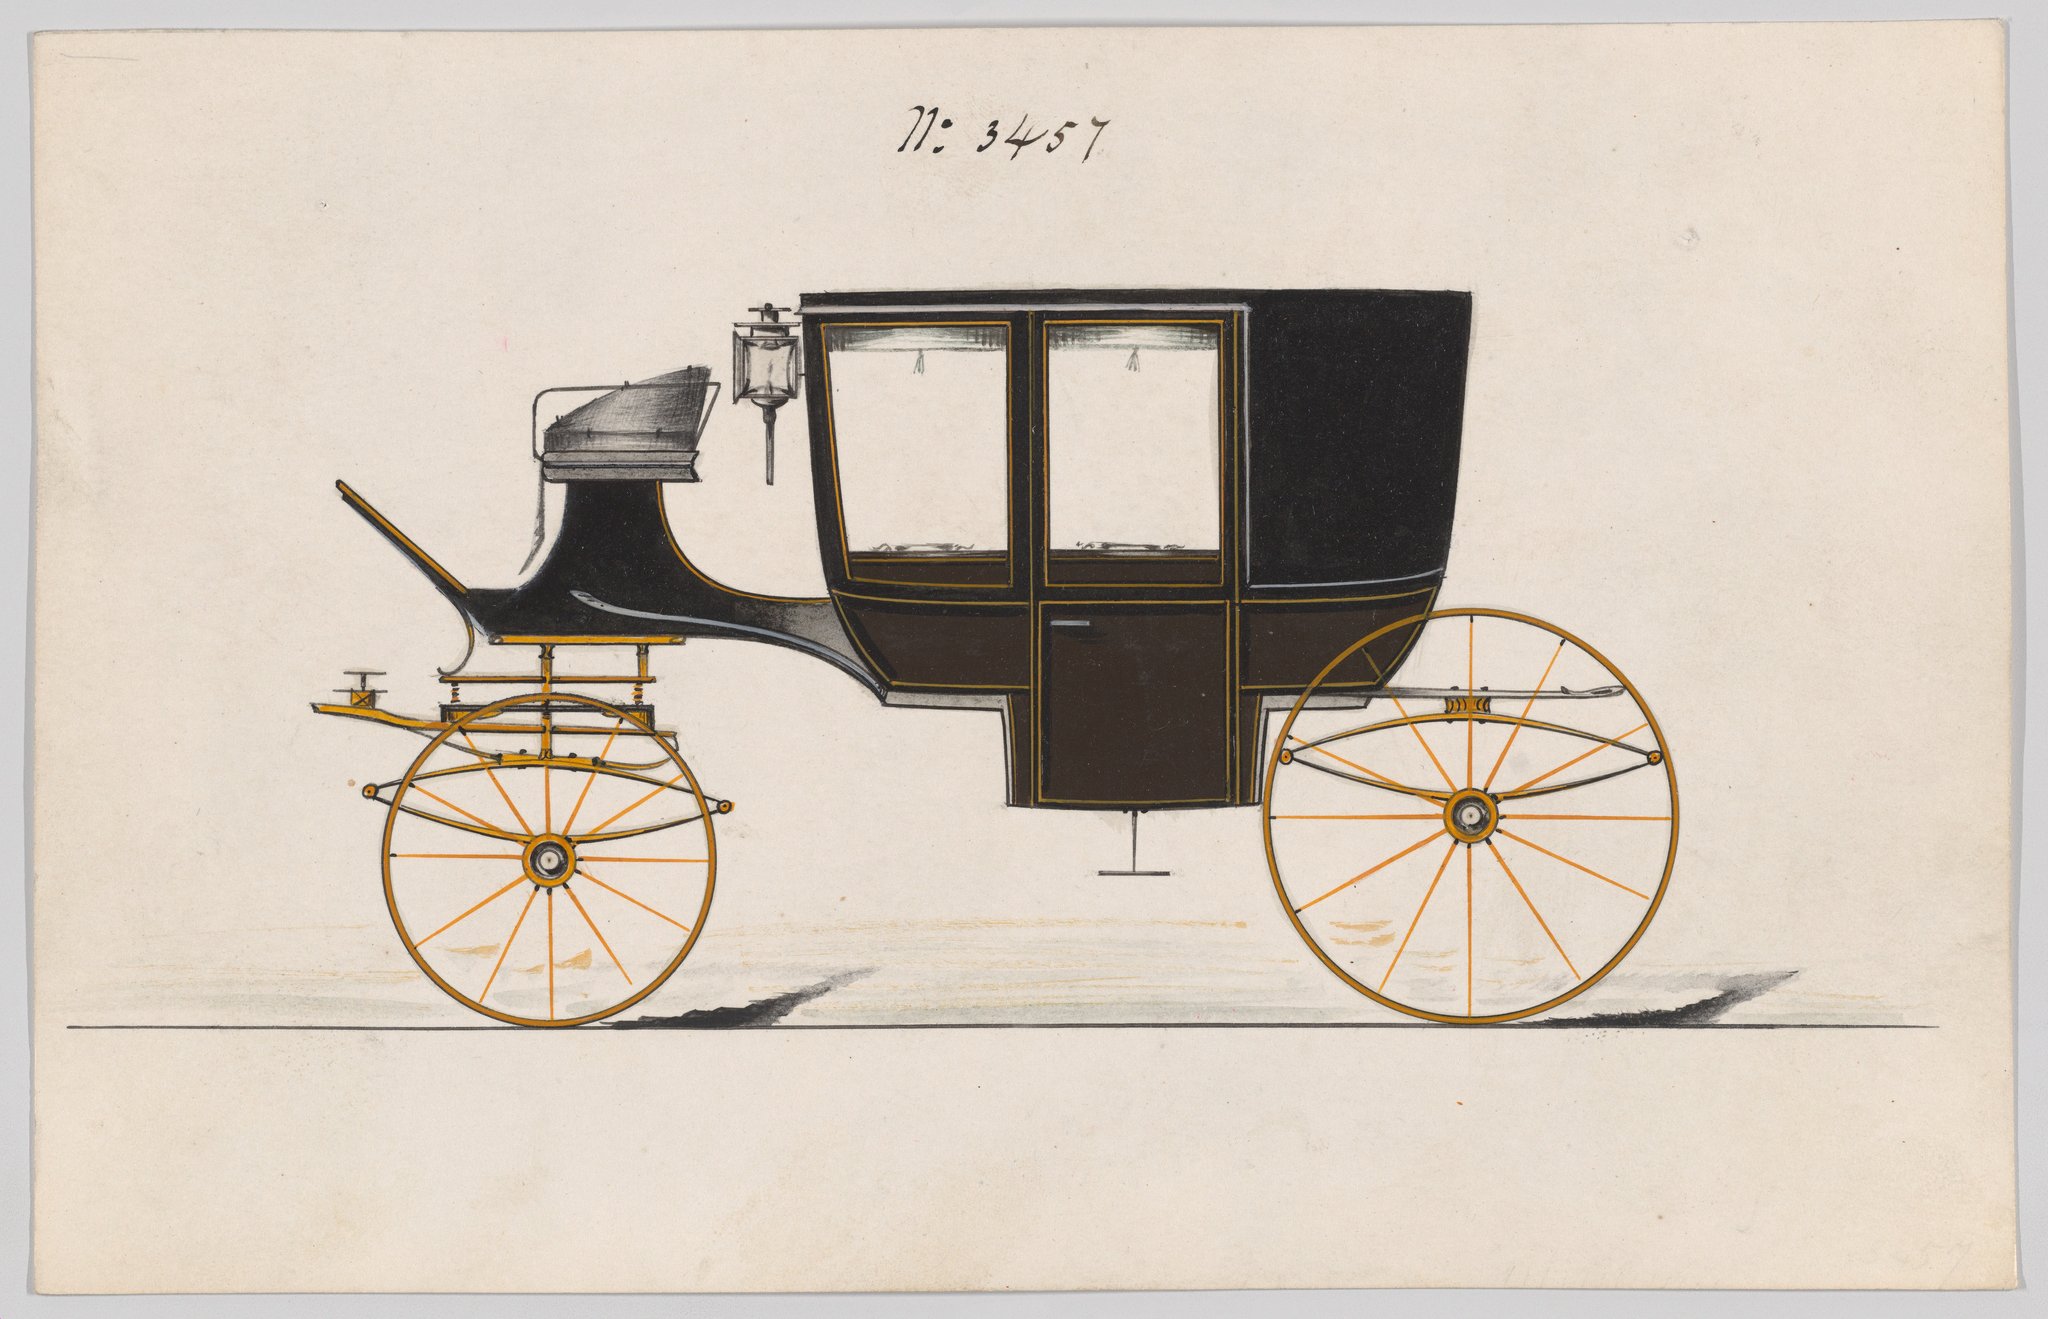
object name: drawing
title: Coach #3457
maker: brewster & co.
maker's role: manufacturer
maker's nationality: american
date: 1878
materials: gouache, ink, watercolor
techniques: pen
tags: carriages